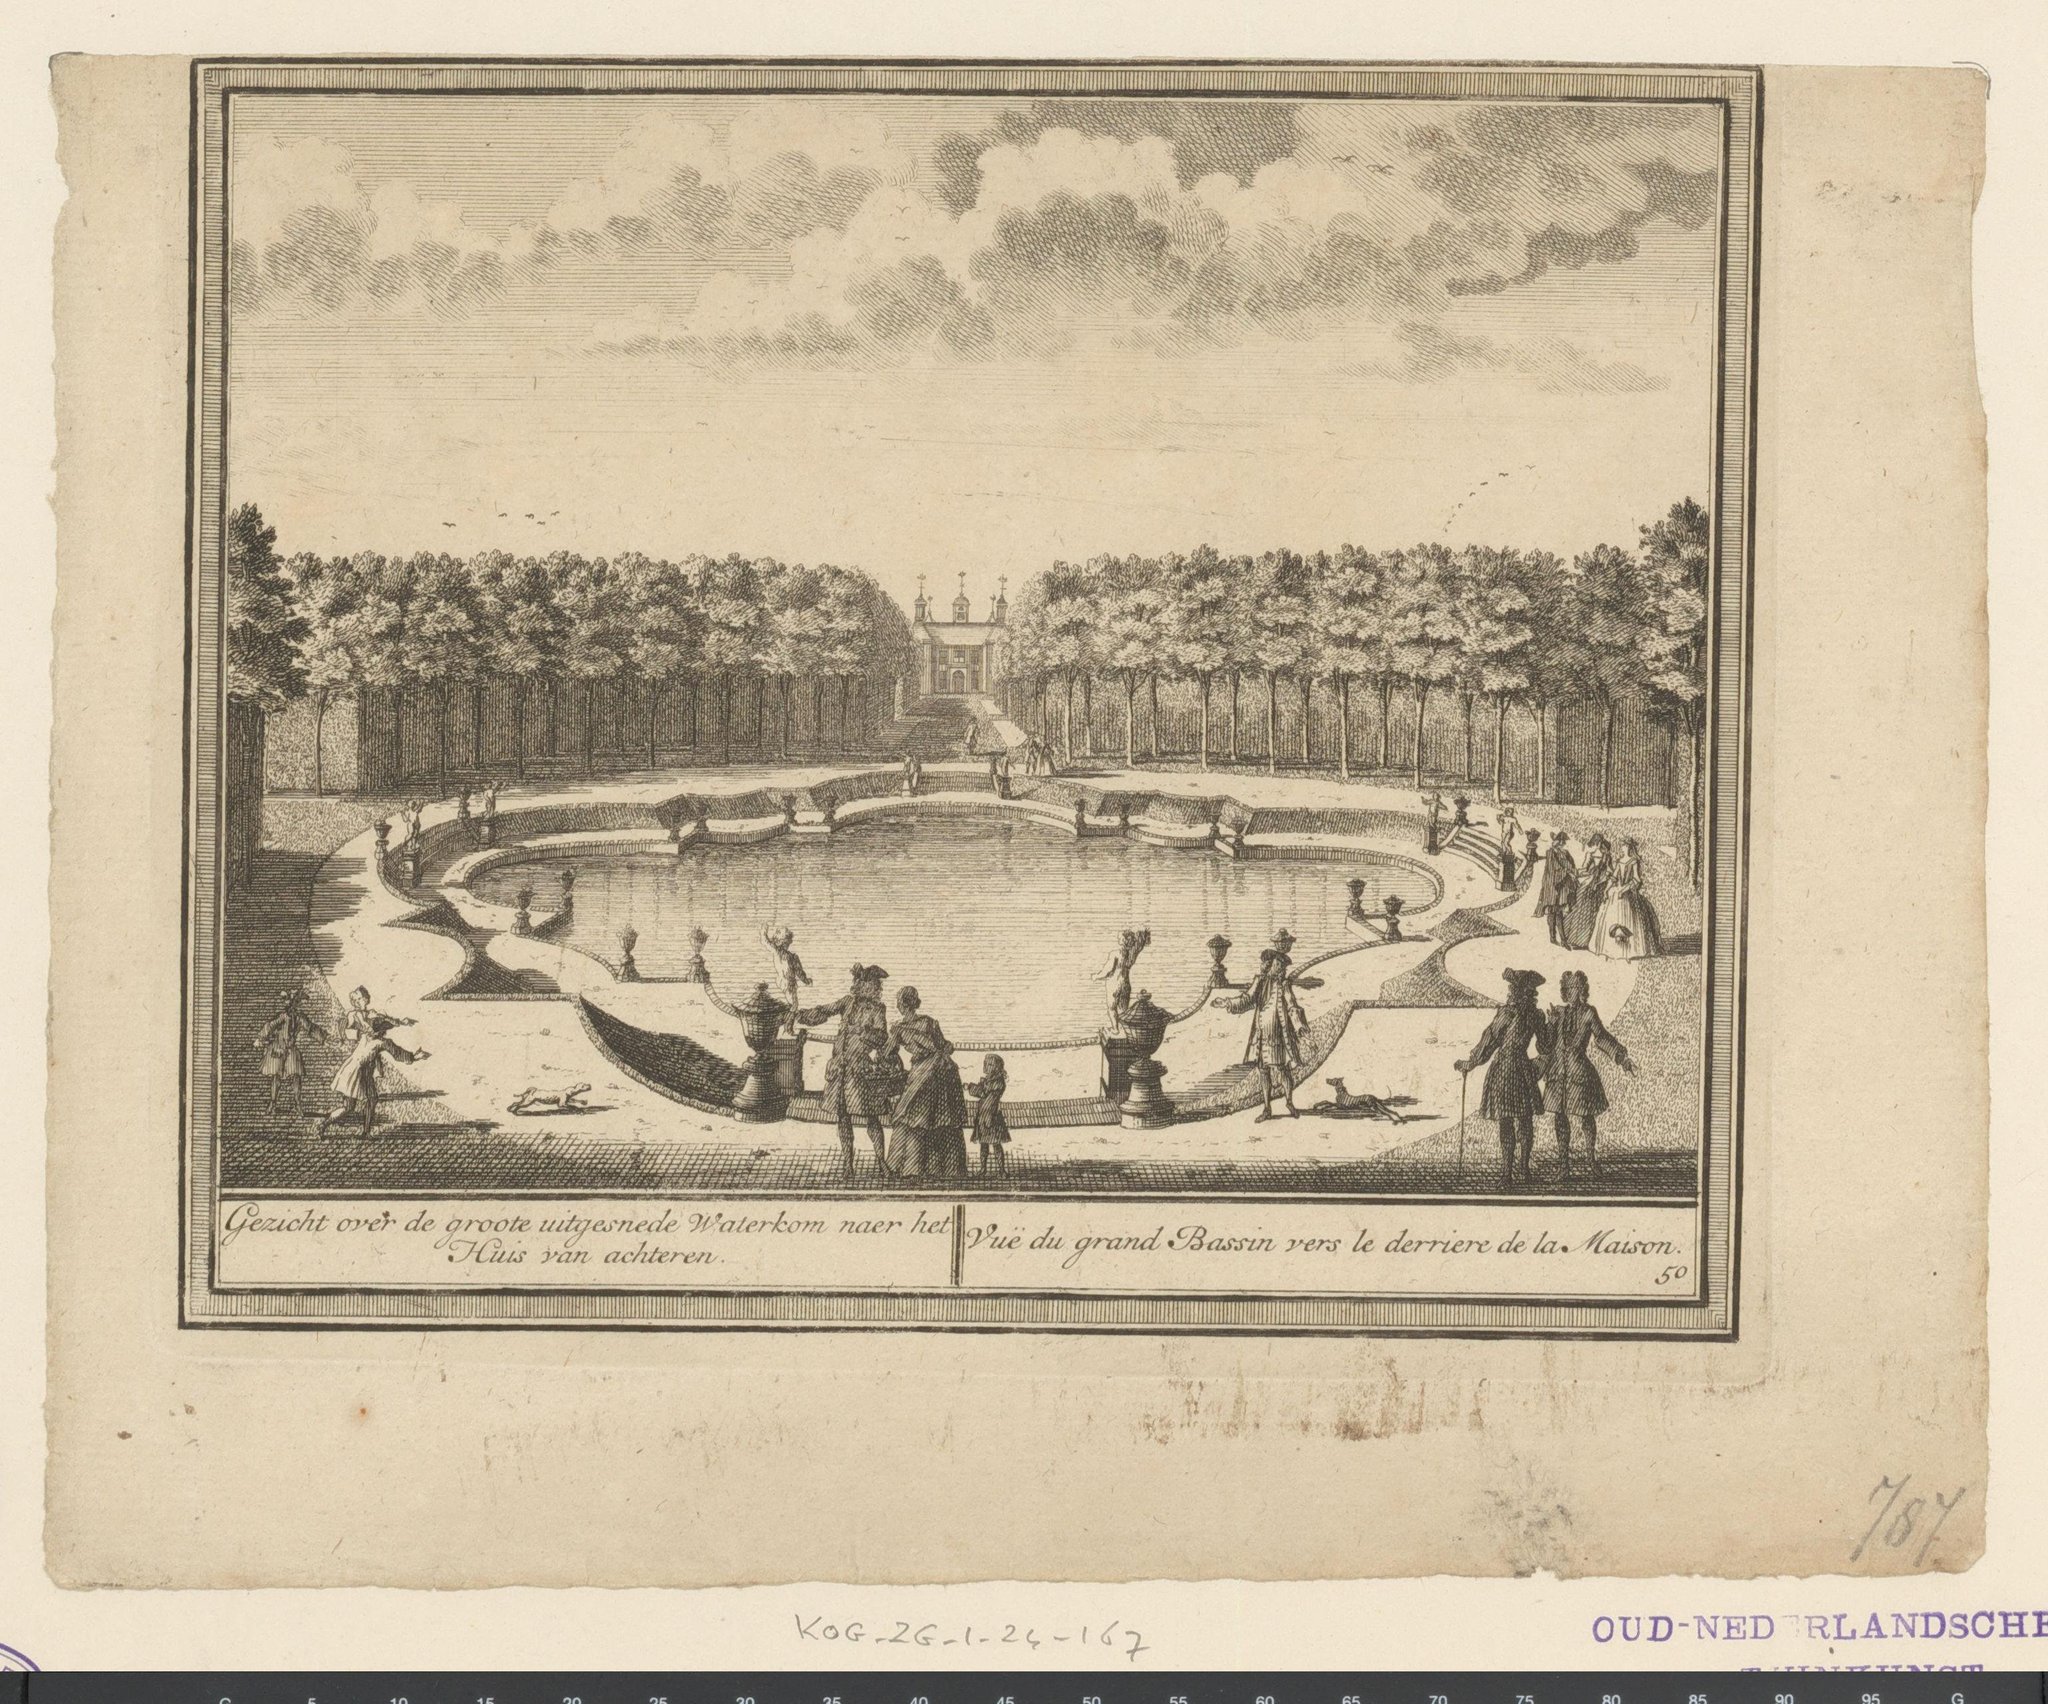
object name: print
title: Uitgesnede vijver en achtergevel van de buitenplaats 't Klooster te Haarlem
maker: hendrik de leth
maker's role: draughtsman, print maker, publisher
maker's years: 1703-1766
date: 1729-1732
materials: paper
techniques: engraving, etching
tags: french or architectonic garden; formal garden, garden pond, country-house, haarlem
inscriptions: stamp, collector's mark: Lugt 1641, stamp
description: Prent mogelijk uit: Brouërius van Nidek, Matthaeus. Het zegepralend Kennemerland, vertoond in 100 heerlyke gezichten. Amsterdam: Jan Roman, s.a. Of uit: Brouërius van Nidek, Matthaeus. Het zegepralend Kennemerland, vertoond in veele heerlyke gezichten. Amsterdam: Andries en Hendrik de Leth, s.a [1729-1732].